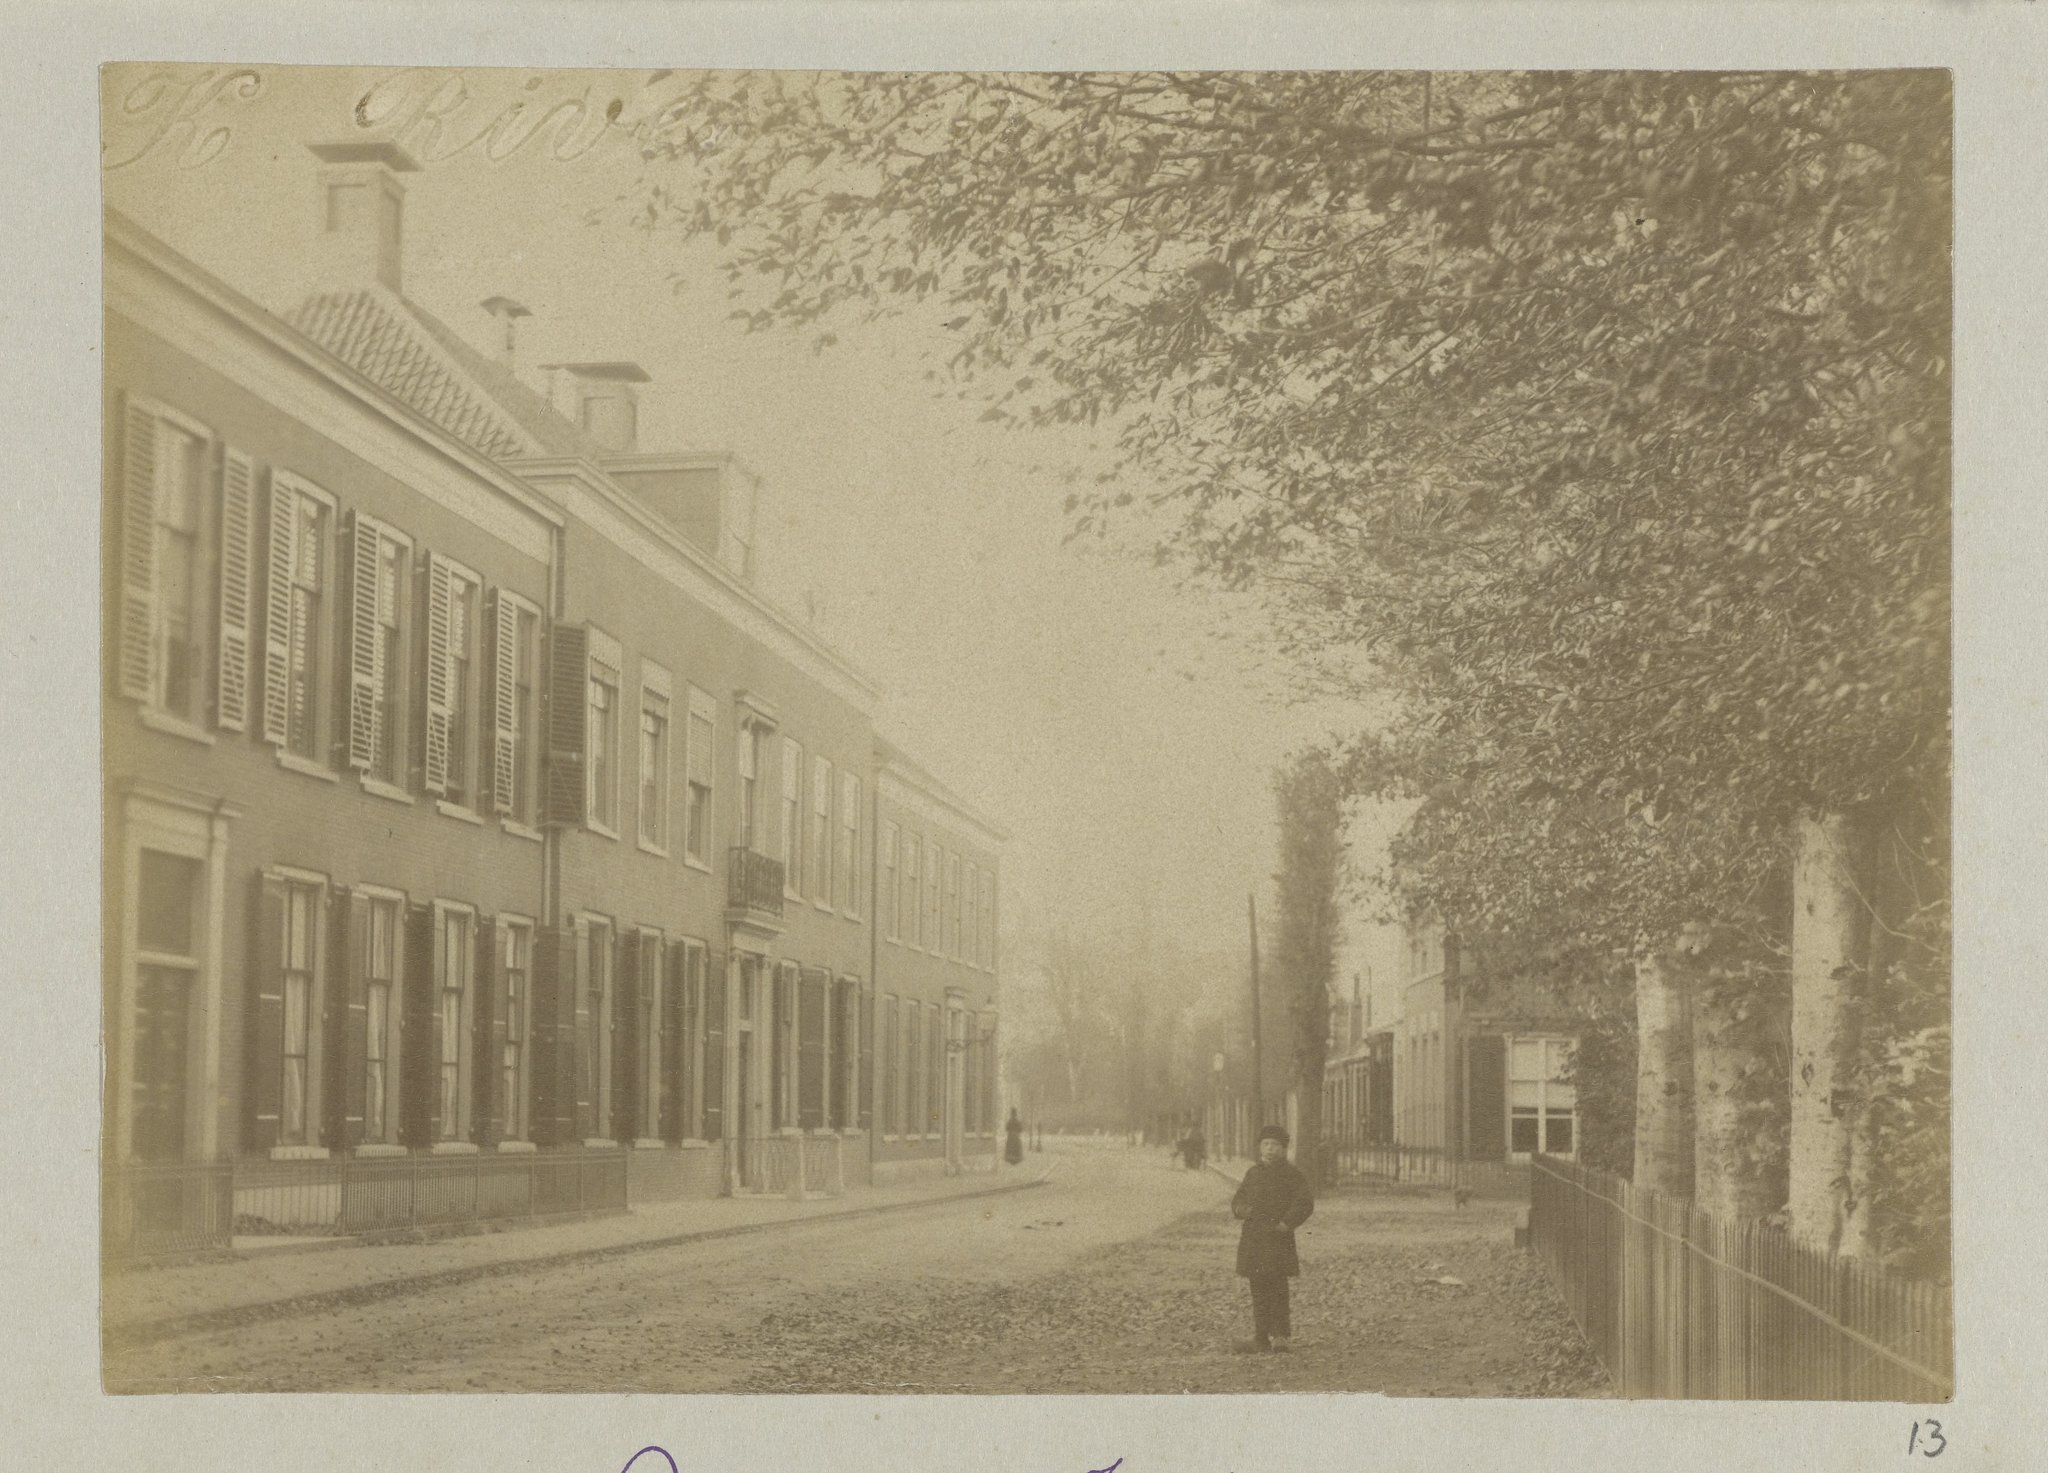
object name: photograph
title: Straatgezicht van de dorpsstraat in Zeist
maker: henry pauw van wieldrecht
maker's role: fotograaf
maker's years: 1863-1912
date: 1888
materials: paper, photographic support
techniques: albumen print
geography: netherlands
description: Straatgezicht van de dorpsstraat in Zeist, met zicht op huize “Beek en Royen”.